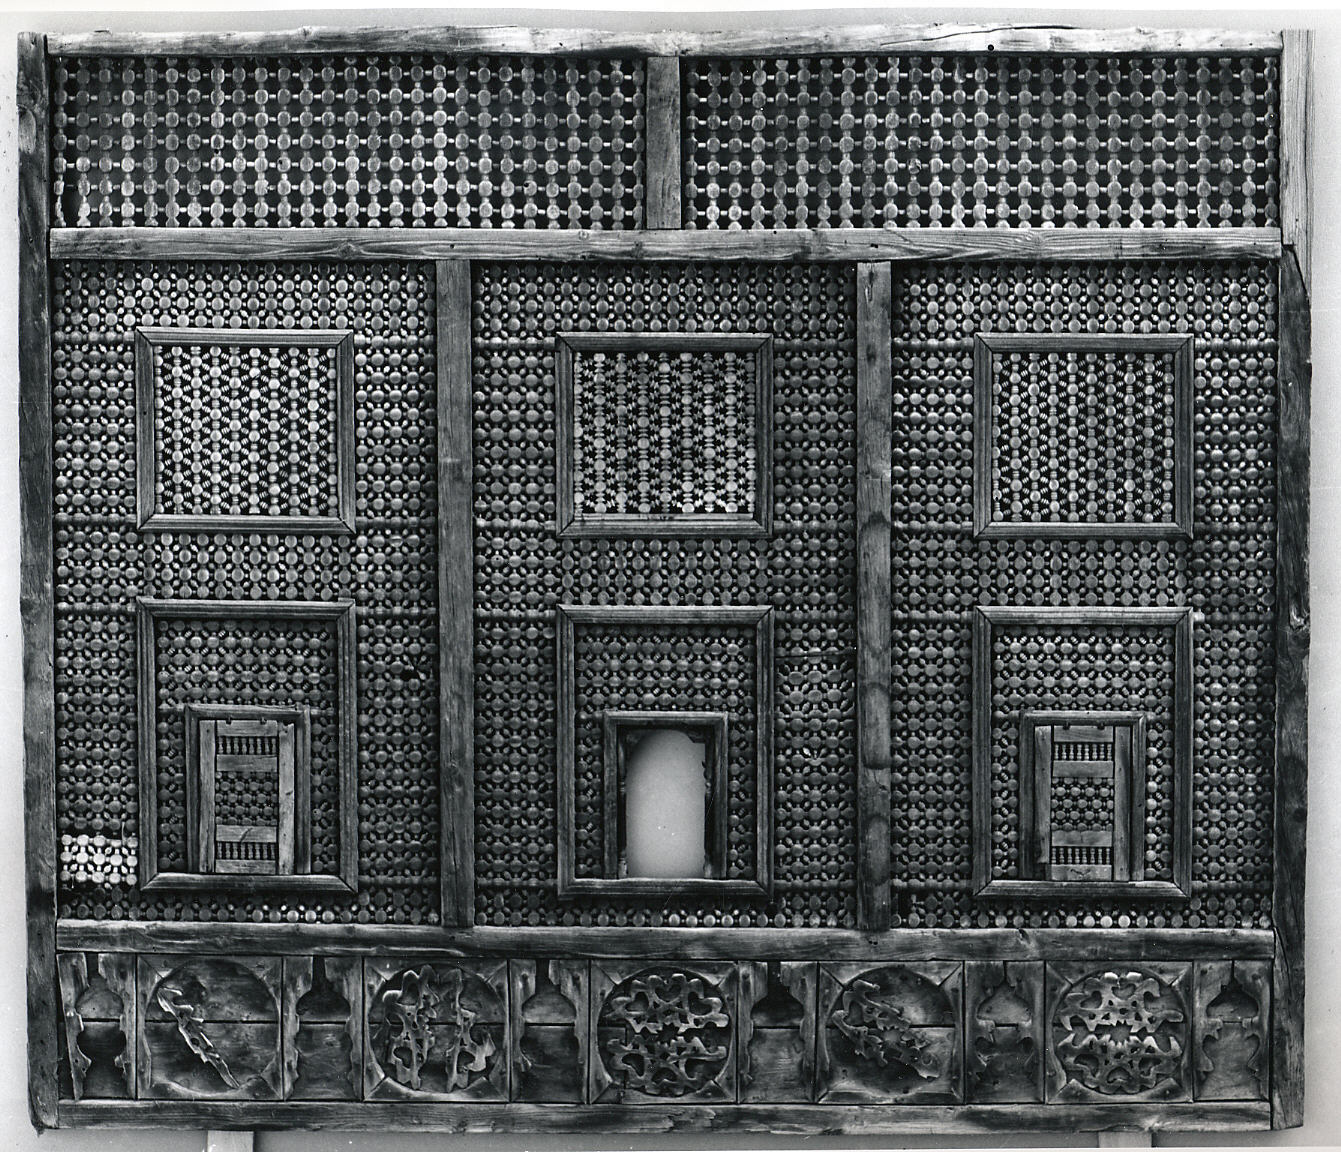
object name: screen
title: Mashrabiya Screen with Medallions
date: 1701-1800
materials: wood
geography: egypt